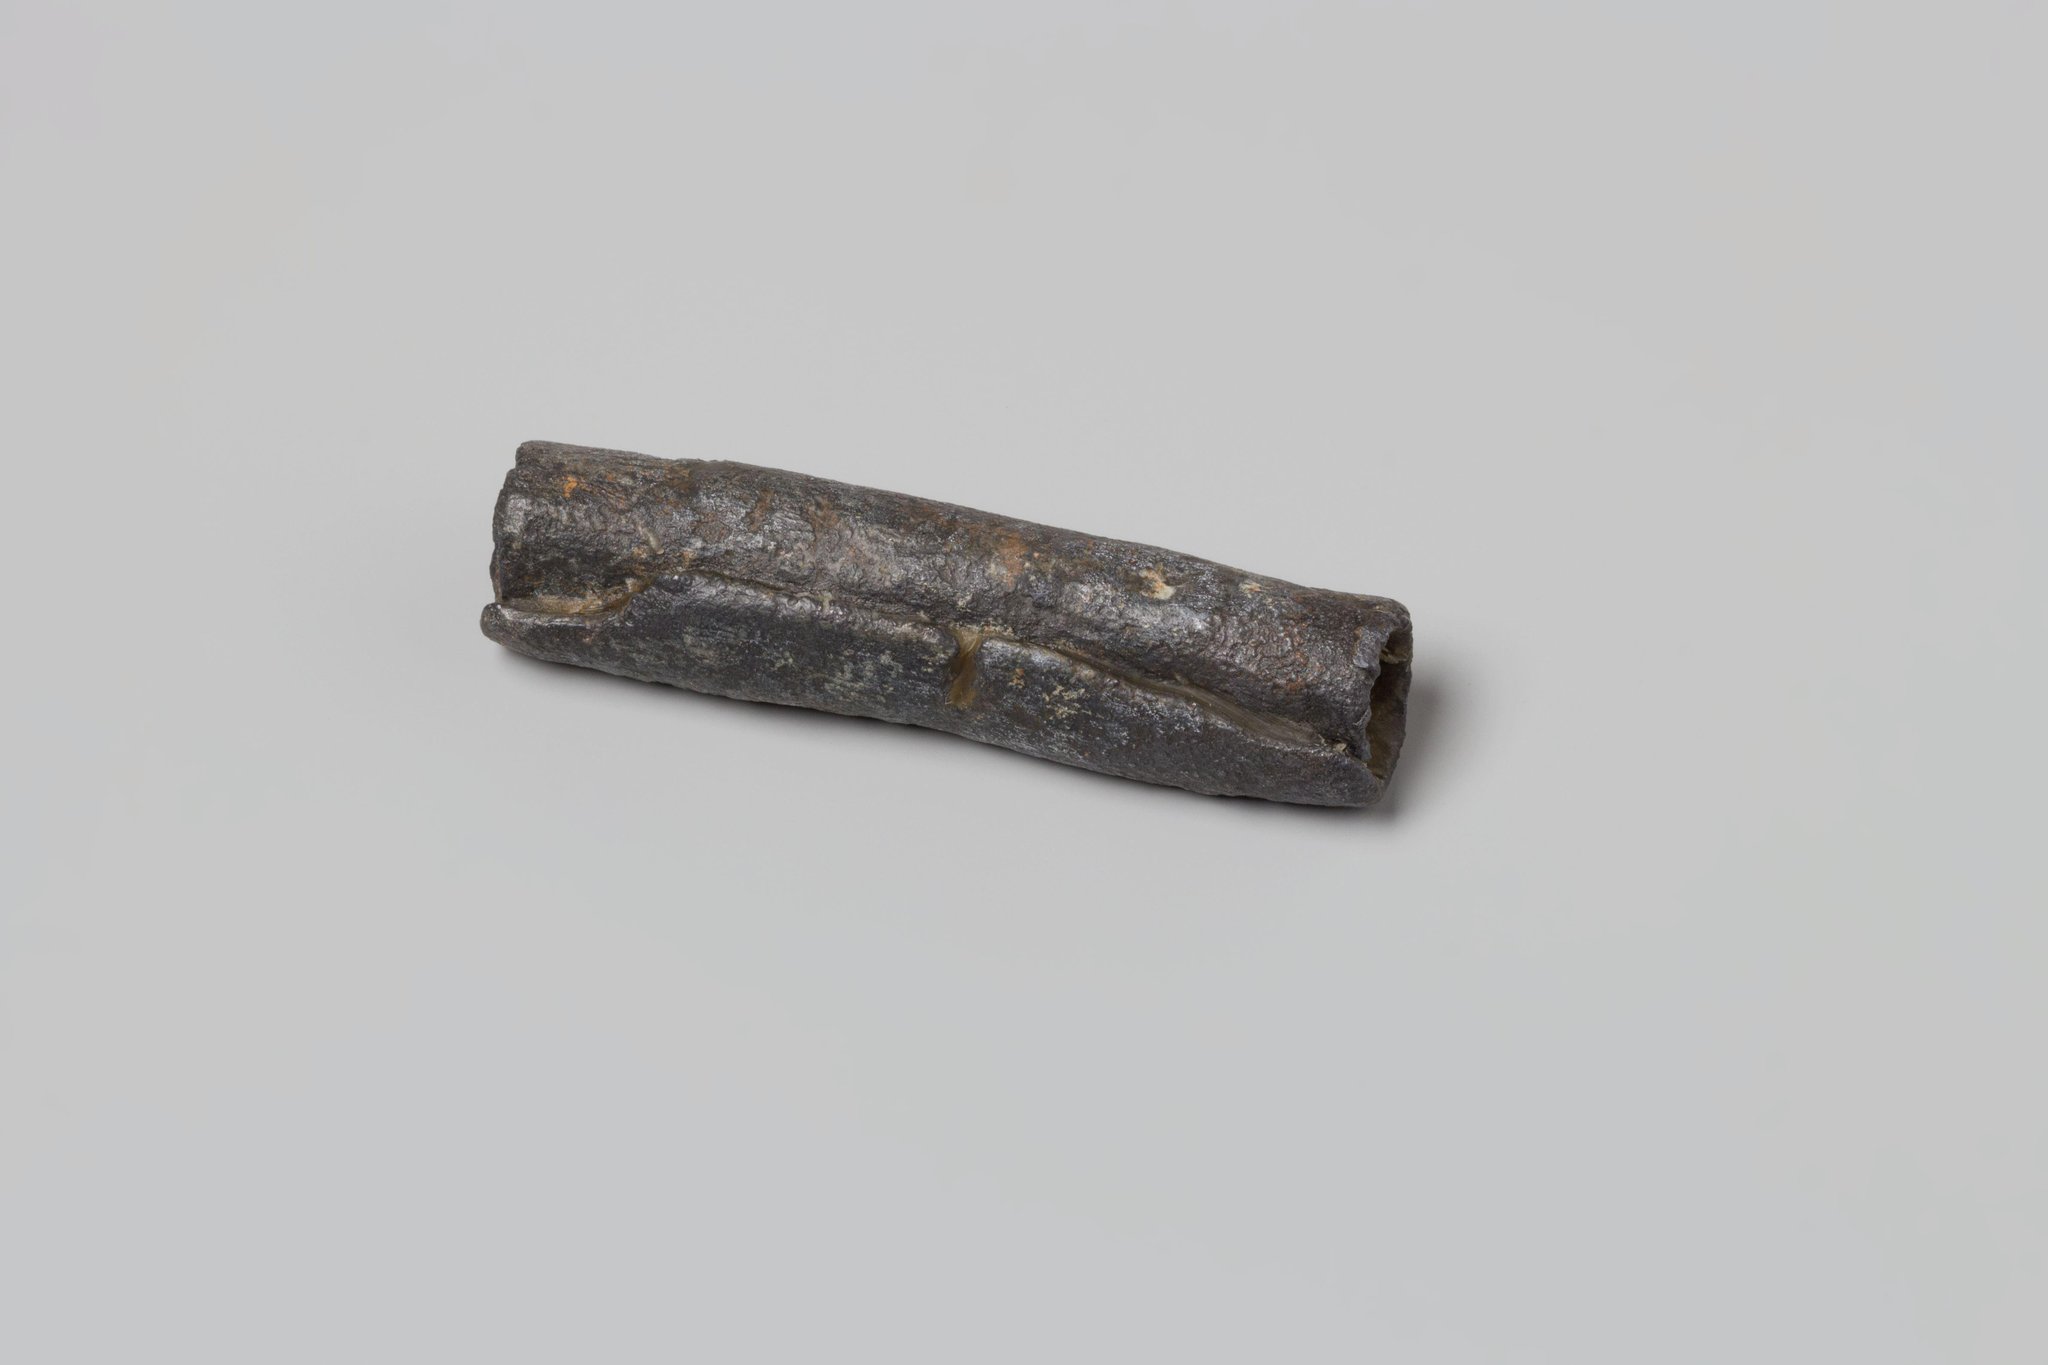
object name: lead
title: Vislood uit het wrak van de in 1735 vergane Oost-Indiëvaarder 't Vliegend Hart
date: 1700-1950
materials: lead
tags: 't vliegend hart (schip), verenigde oostindische compagnie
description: Uit een brok concretie kwam dit vislood tevoorschijn. Deze tot een buisje gerolde loden plaat is zilvergrijs en maakte ooit onderdeel uit van de reep van een vislijn (bovenaan het staande want of aan een beuglijn). Deze netten zijn of afkomstig van TVliegend Hart zelf of ze zijn van vissers die hun netten aan het wrak verloren. Roll of lead.